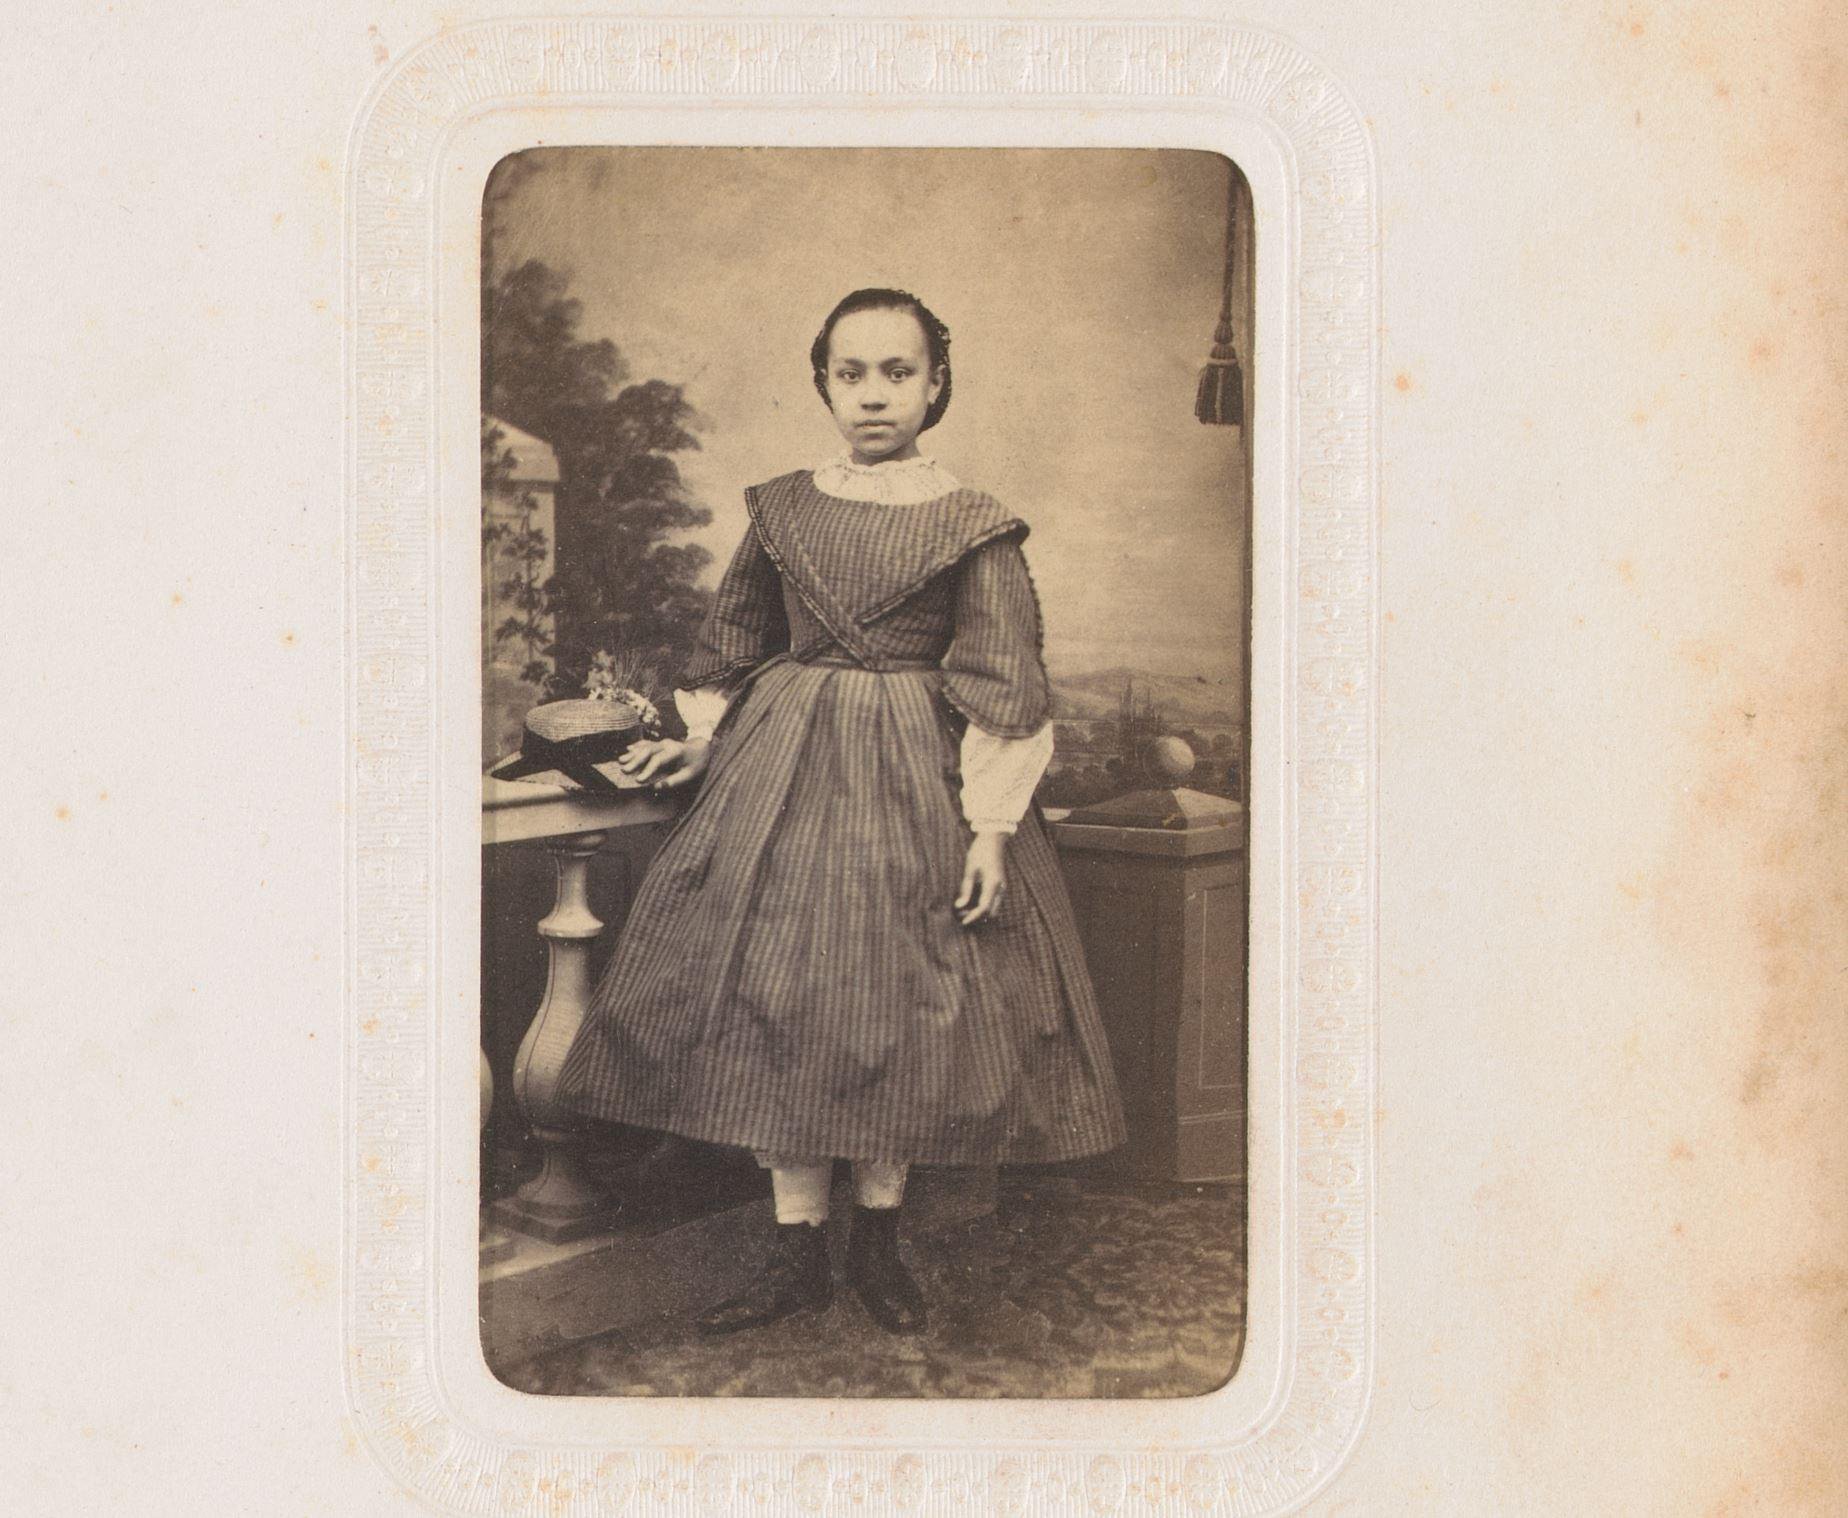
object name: photograph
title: Portret van een meisje, staand bij een balustrade met hoed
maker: Anonymous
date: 1860-1900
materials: cardboard, photographic support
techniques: albumen print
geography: netherlands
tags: historical persons - bb - woman, girl (child between toddler and youth), head-gear: hat, balustrade